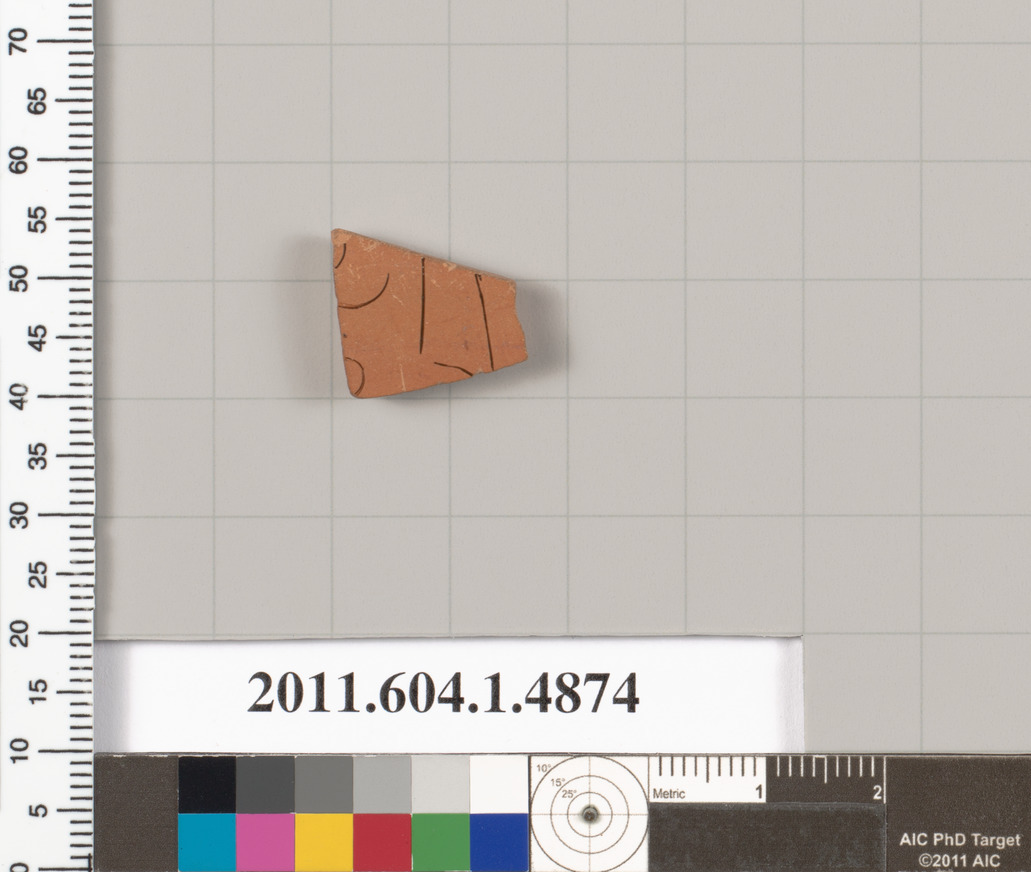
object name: kylix fragment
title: Terracotta fragment of a kylix (drinking cup)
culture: greek, attic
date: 475-451 BCE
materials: terracotta